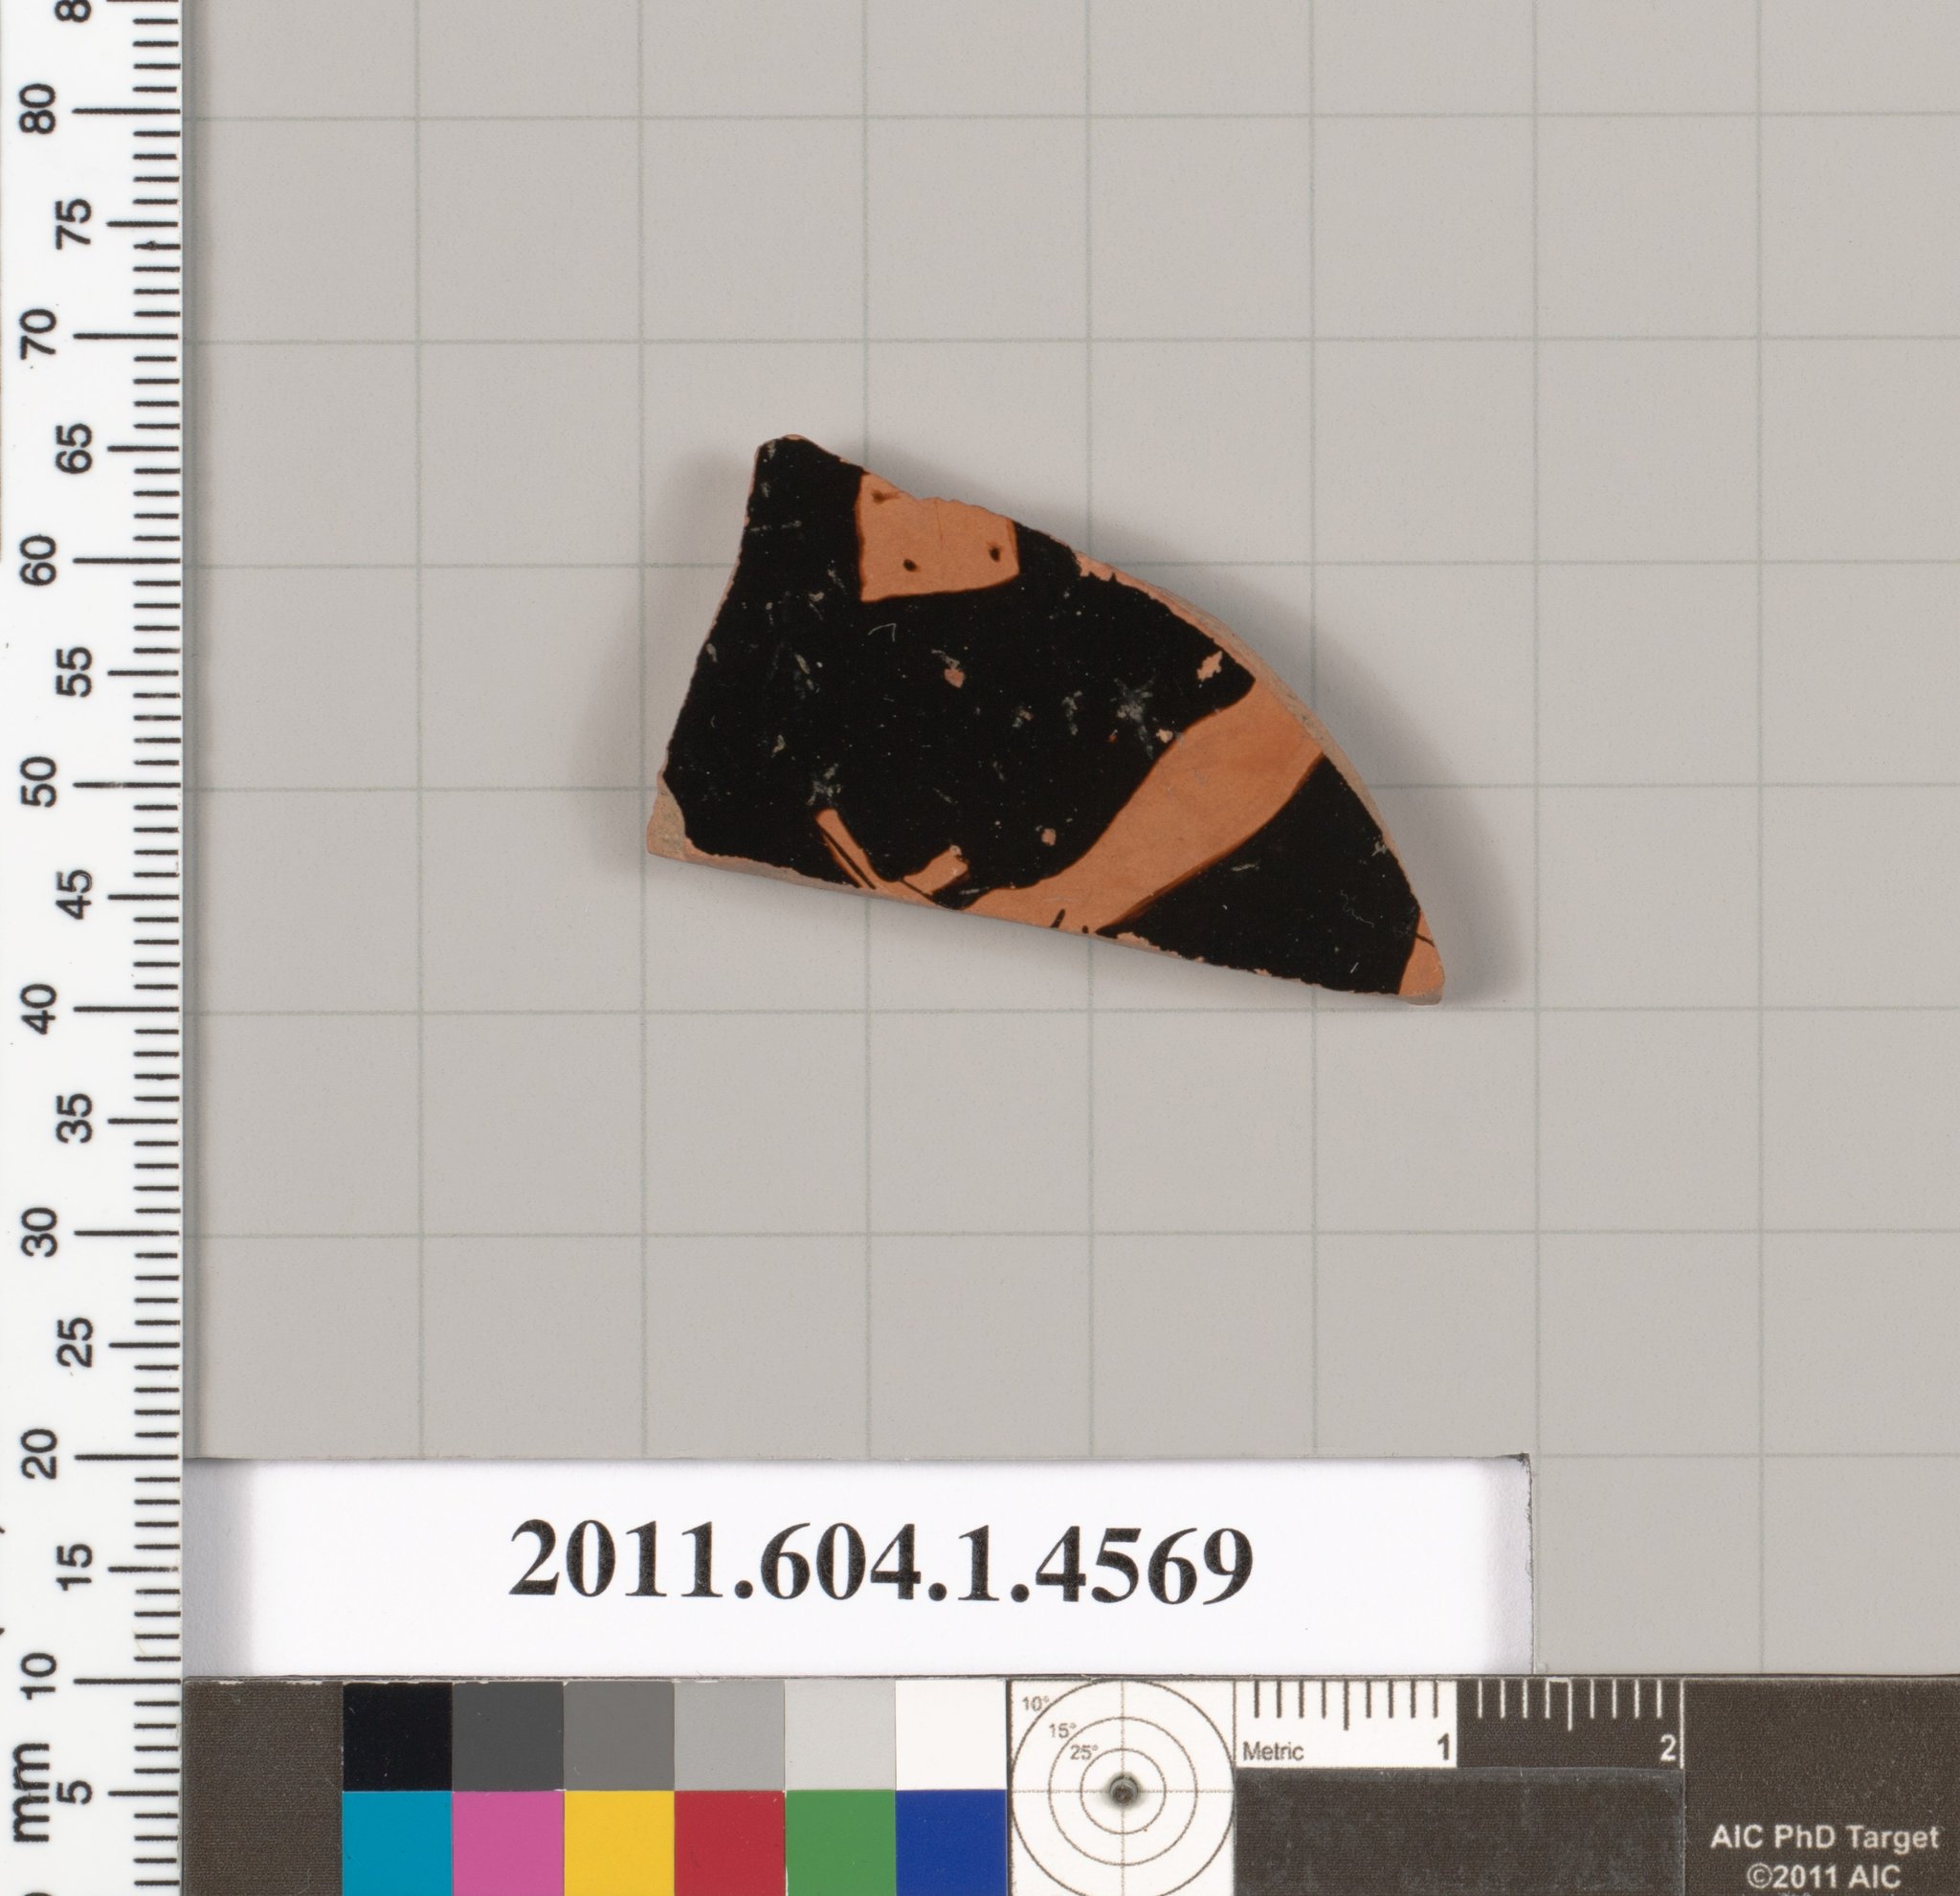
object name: kylix fragment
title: Terracotta fragment of a kylix (drinking cup)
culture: greek, attic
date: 490-470 BCE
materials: terracotta